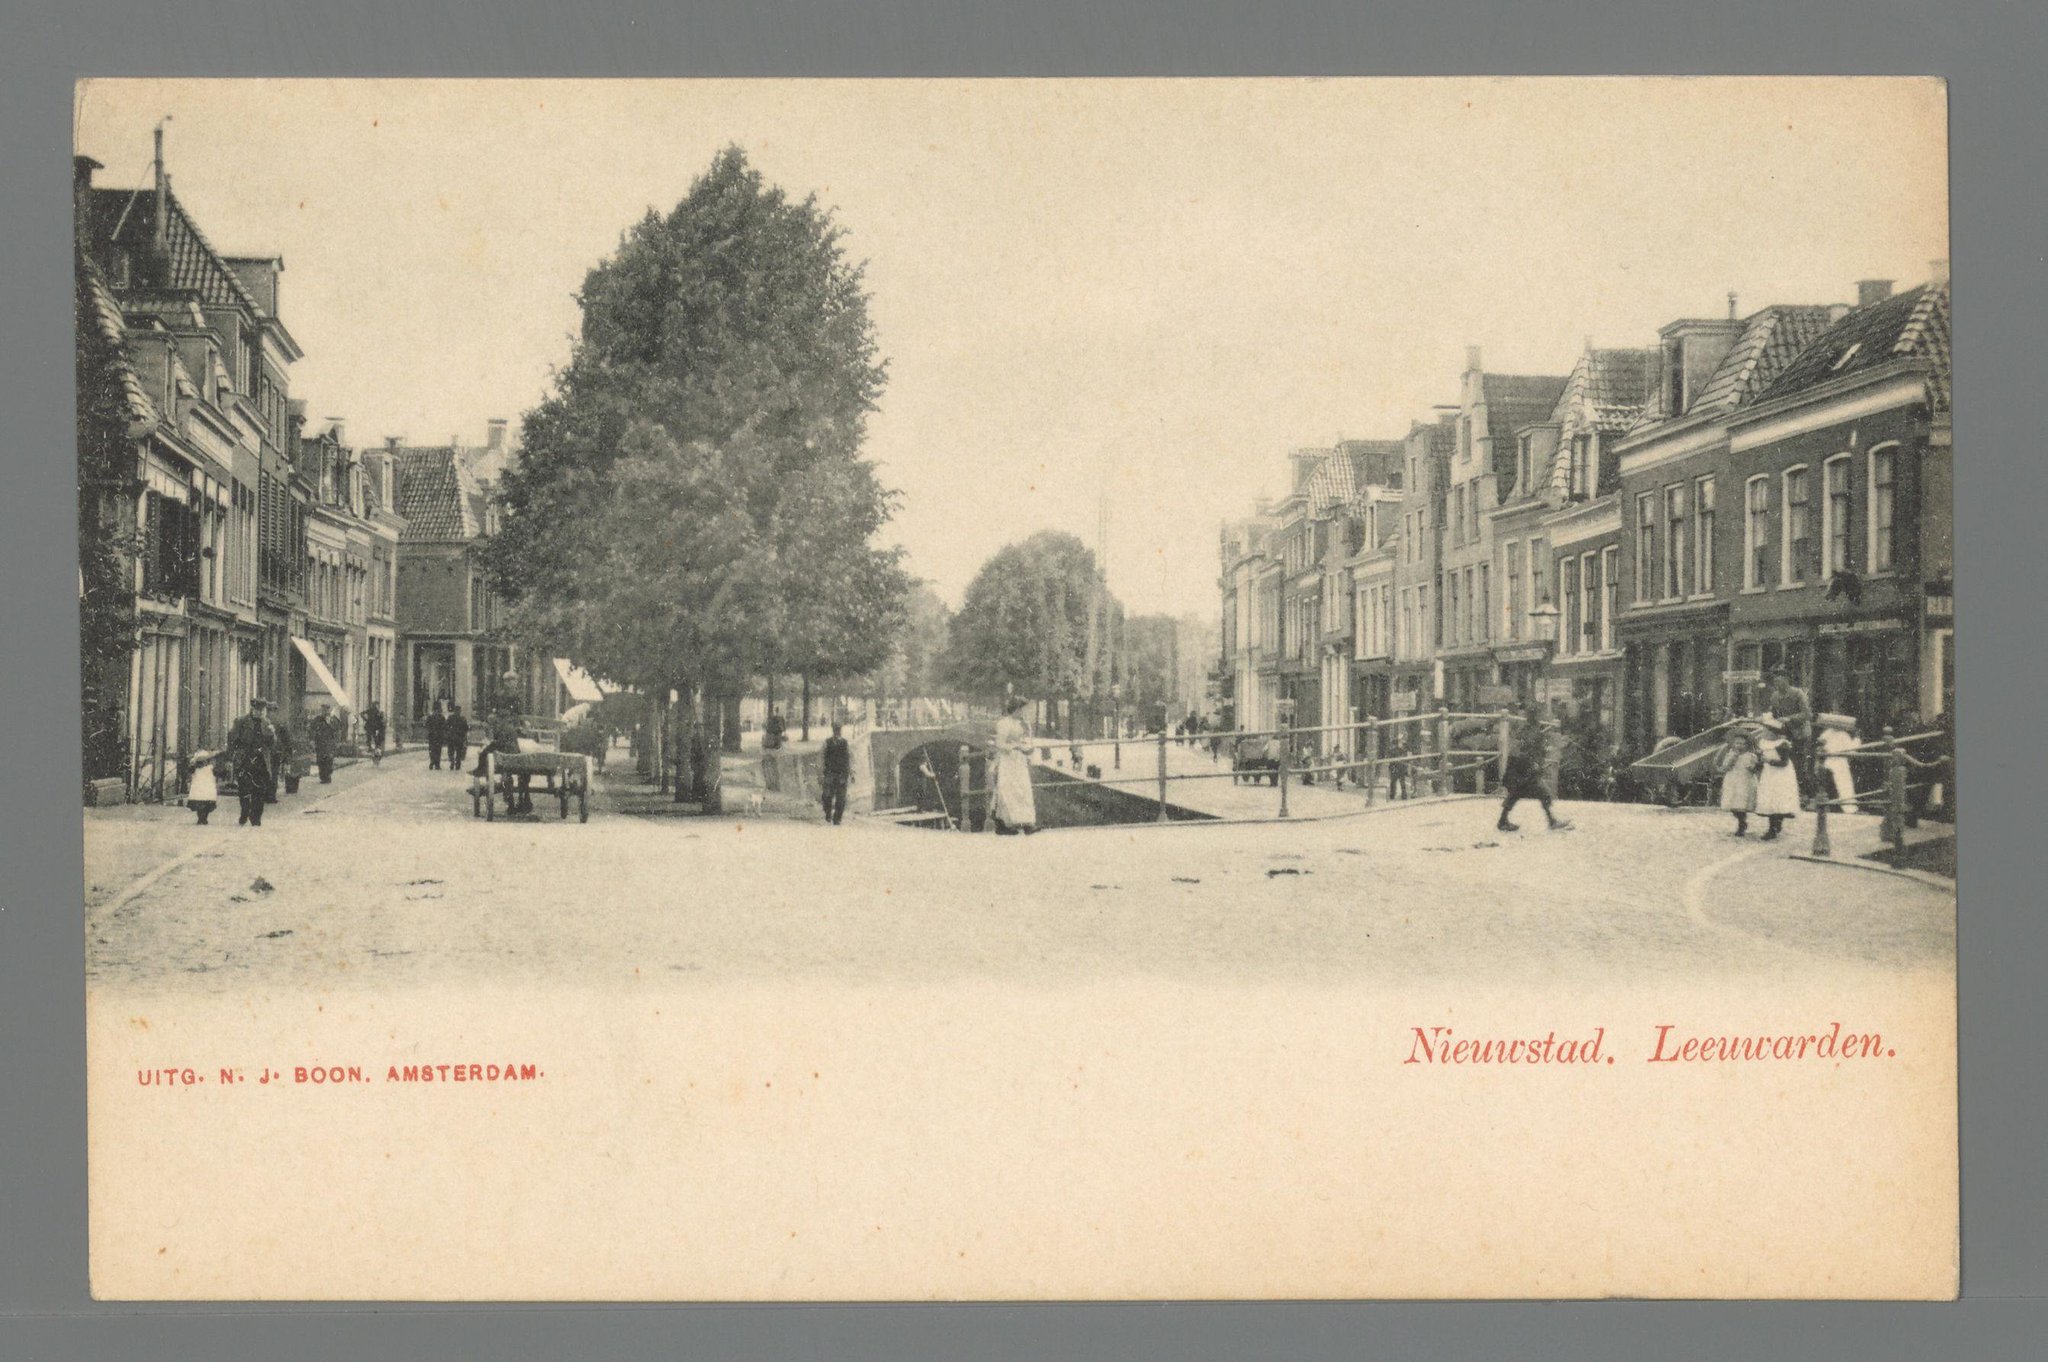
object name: ansichtkaart, prentbriefkaart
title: Nieuwstad. Leeuwarden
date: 1897-1905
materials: cardboard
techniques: photograph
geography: amsterdam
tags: canals, waters (in city), bridge in city across river, canal, etc., street